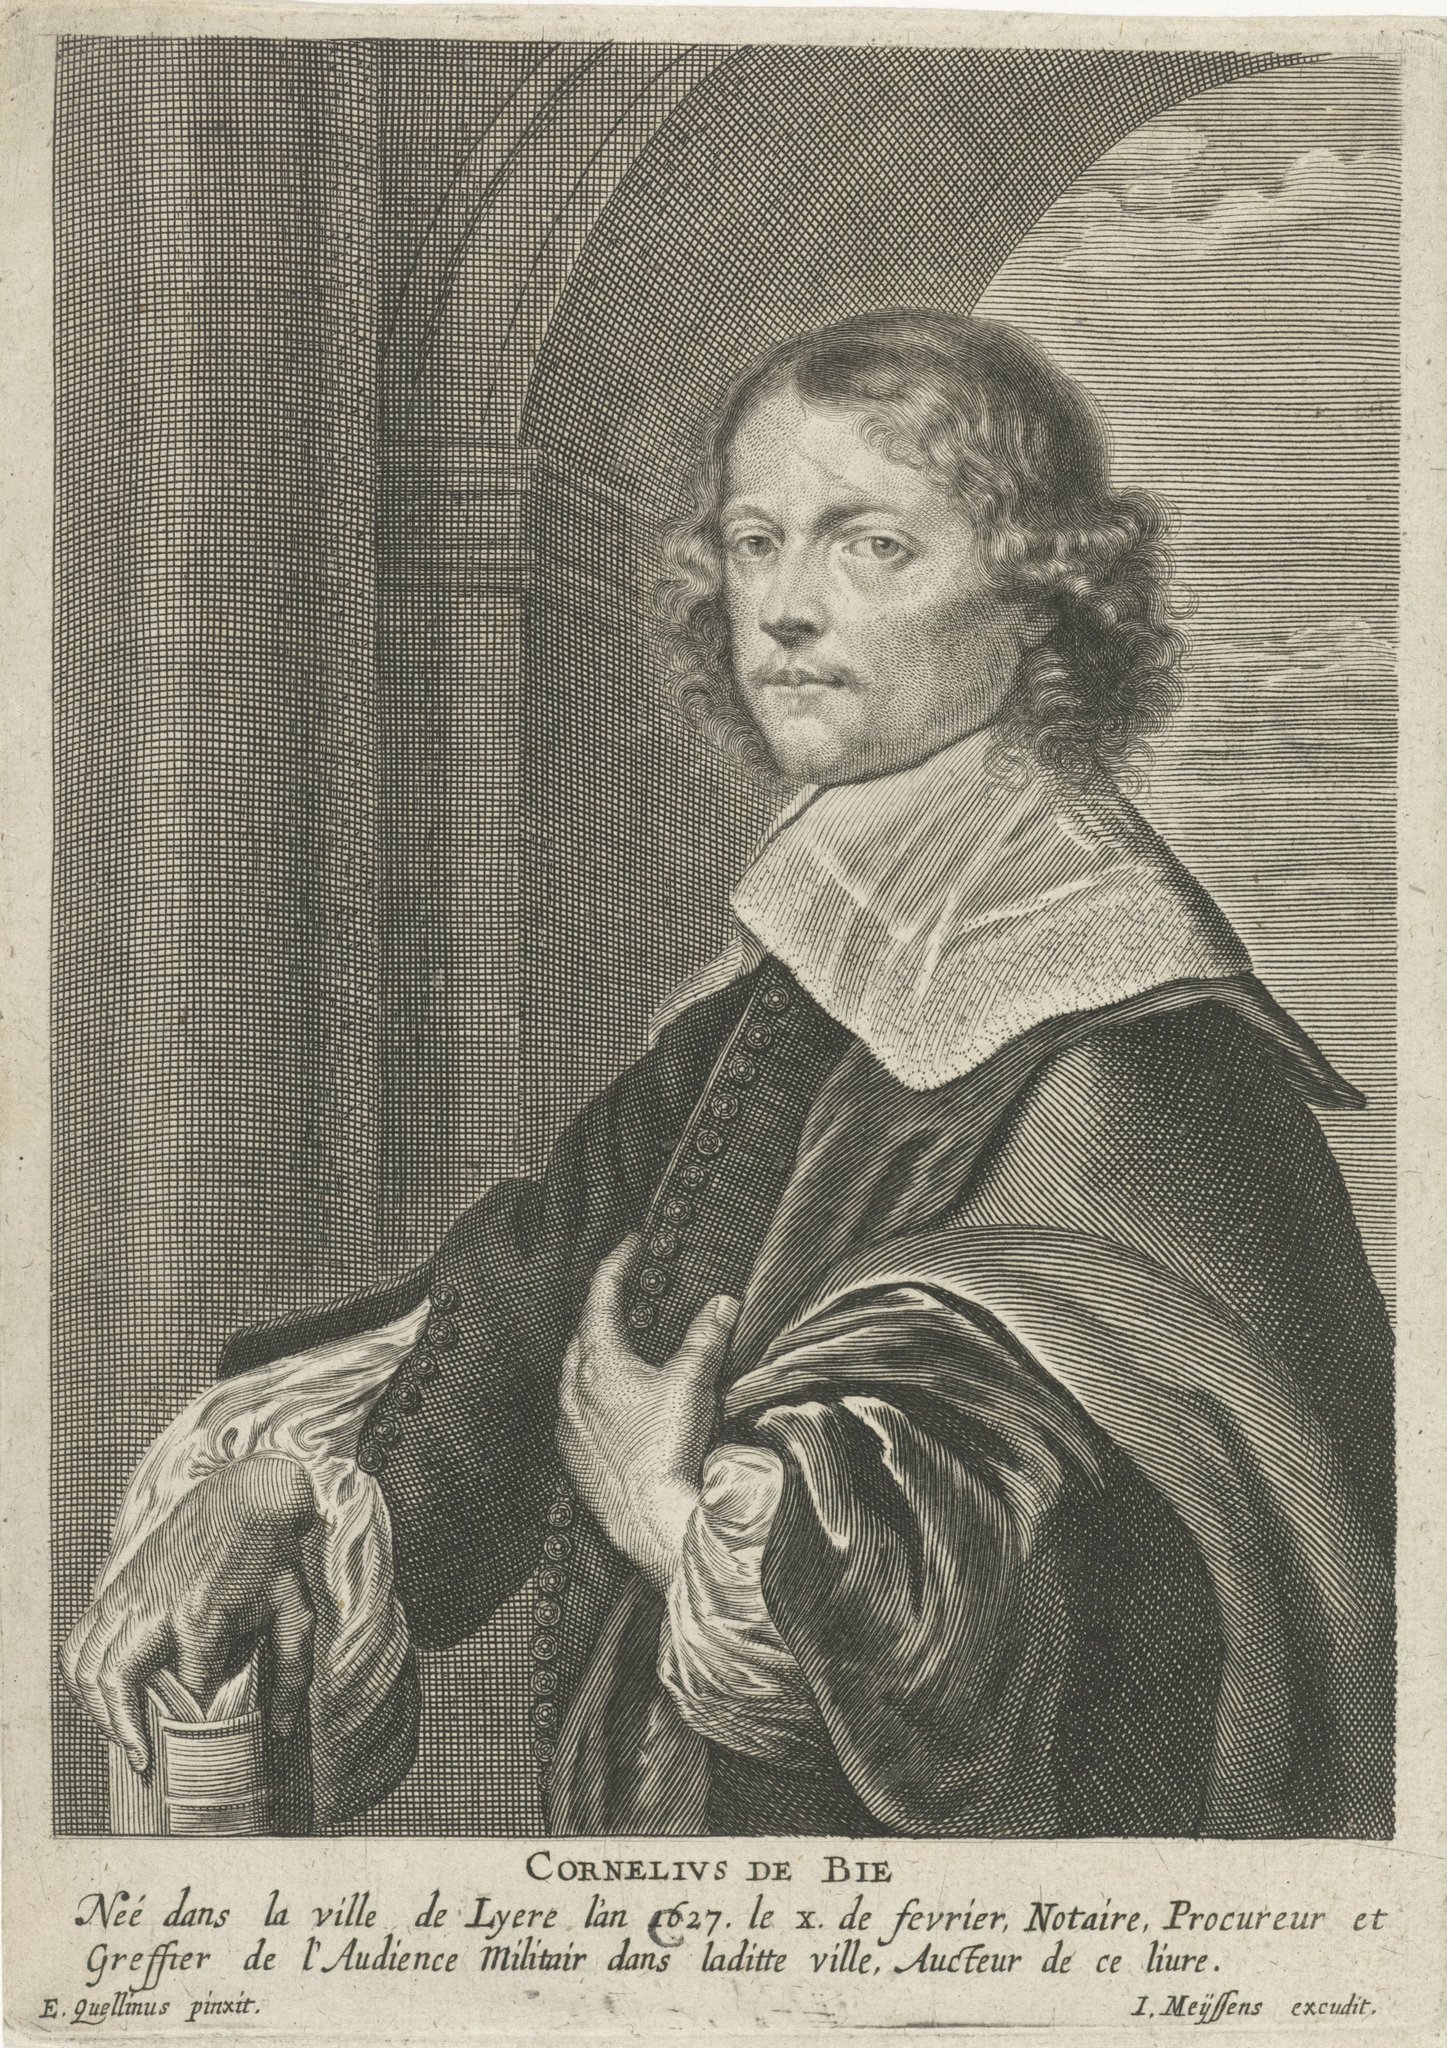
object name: print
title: Portret van Cornelis de Bie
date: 1662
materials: paper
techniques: engraving, letterpress printing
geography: antwerp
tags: cornelis de bie, historical persons, portrait of a writer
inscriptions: collector's mark: Lugt 2228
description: Prent uit: Bie, Cornelis De. Het gulden Cabinet vande edel vry schilder const, inhoudende den lof vande vermarste schilders, architecte, beldthowers ende plaetsnyders van dese eeuw. Antwerpen: Joannes Meyssens, 1662 [1661 foutief op titelpagina], p. 17. Huidige staat (ongenummerd) mogelijk eerder gebruikt in: Meyssens, Joannes. Image de divers hommes desprit sublime qui par leur art et science deburovent vivre eternellement et des quels la louange et renommée faict estonner le monde. 2 dln. Antwerpen: Joannes Meyssens, 1649. Tweede bekende staat (genummerd 23) gebruikt in: Resta, Sebastiano. The true effigies of the most eminent painters and other famous artists that have flourished in Europe. Londen, 1694.